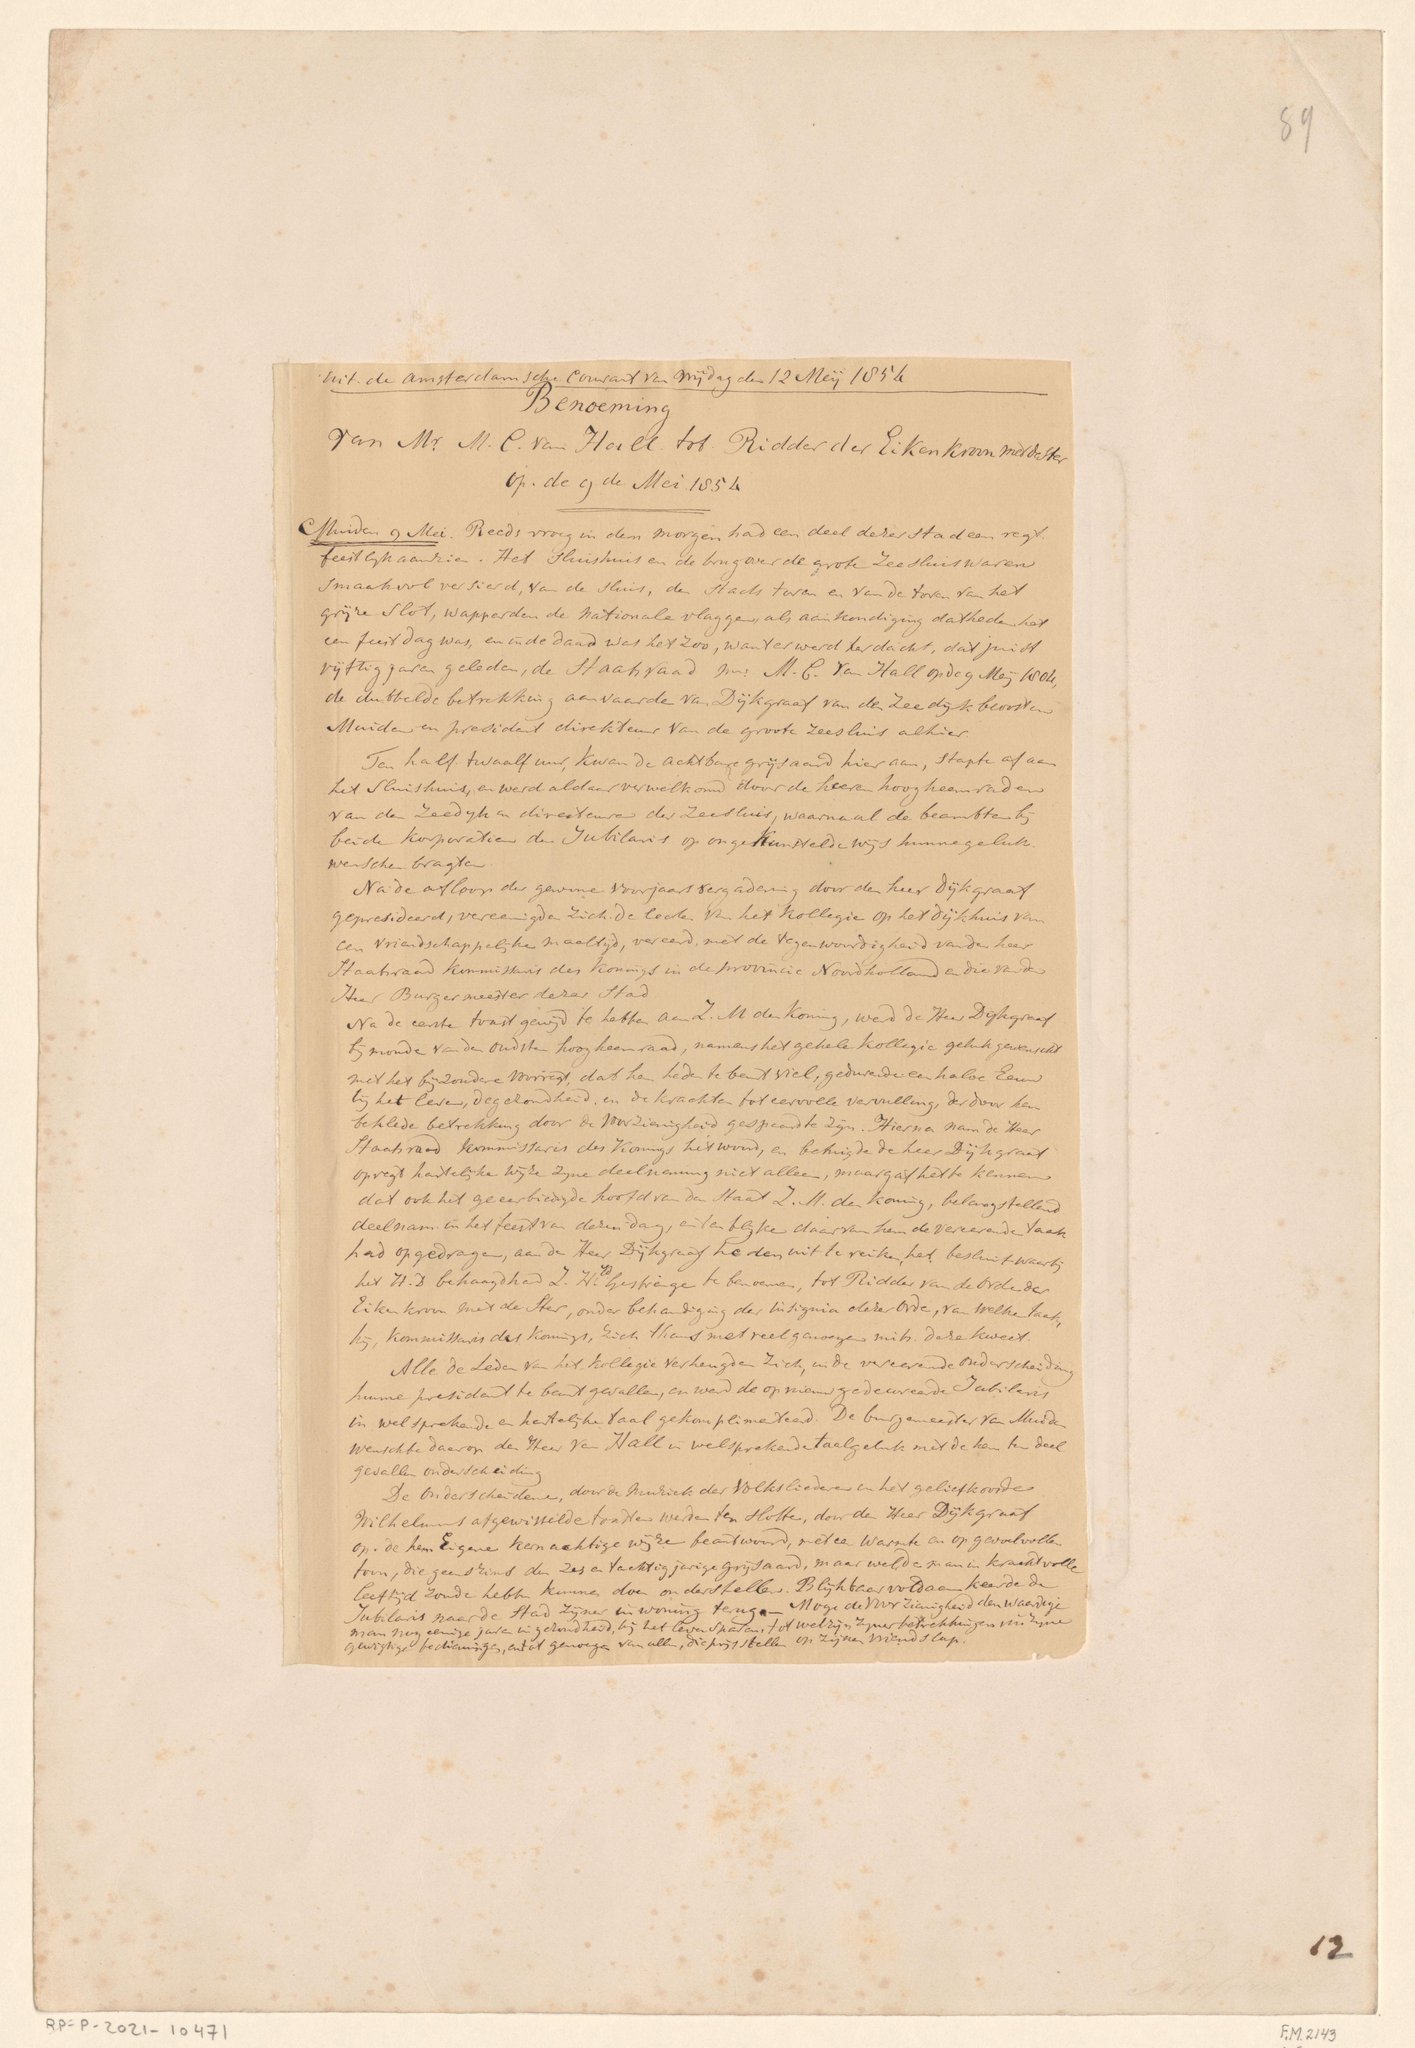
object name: print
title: M.C. van Hall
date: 1848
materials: paper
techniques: engraving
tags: amsterdam, maurits cornelis van hall, historical persons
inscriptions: workshop stamp: ‘François Buffa & Fils, Foyrnisseurs du Roi’, collector's mark: Lugt 2228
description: Over het portret is een blad met handgeschreven tekst geplakt, dat opzij gevouwen kan worden. De tekst gaat over de benoeming van Maurits Cornelis van Hall tot de Orde van de Eikenkroon, overgenomen uit de Amsterdamsche Courant van 12 mei 1854.